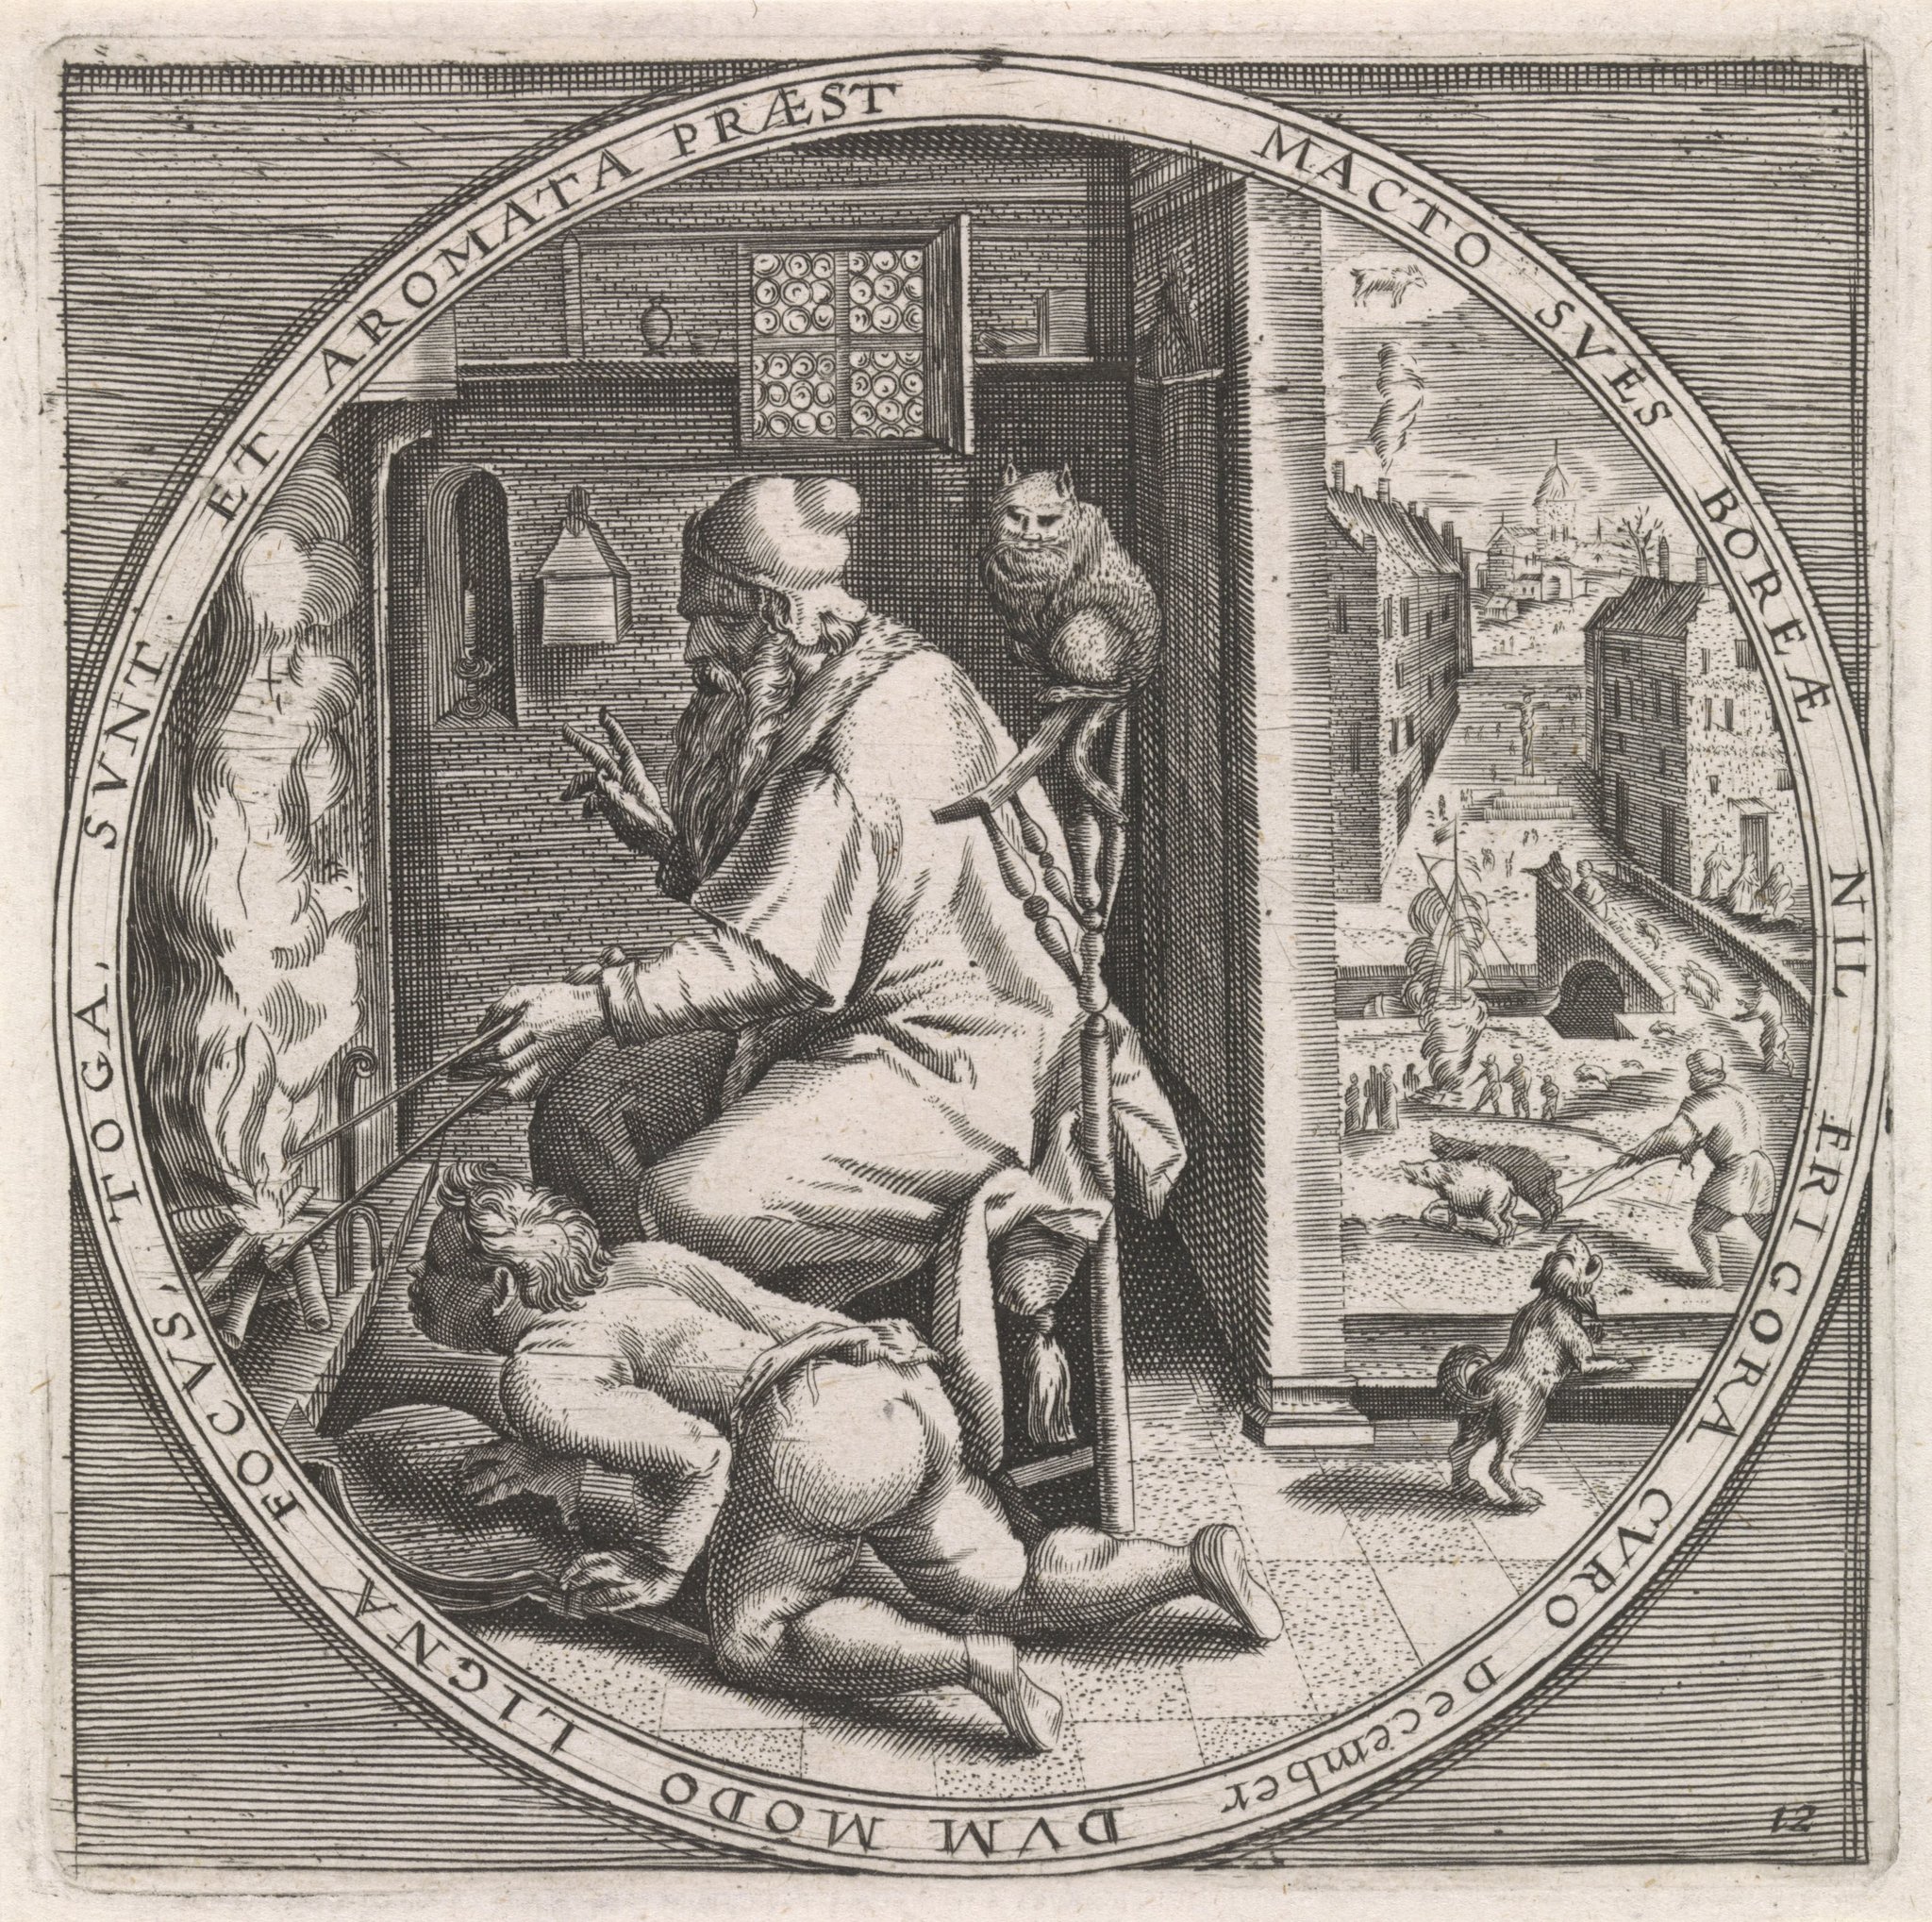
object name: print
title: De twaalf maanden van het jaar verbeeld in scènes uit het volksleven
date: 1574-1687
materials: paper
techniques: engraving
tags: warming oneself at a fire (or hearth, stove, fire-pan, brazier), bellows, december and its 'labours' (+ with zodiacal signs)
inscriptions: collector's mark: Lugt 2228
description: De maand december: een oude man warmt zich aan het vuur van een open haard dat door een jongen wordt aangeblazen. Rechtsboven het teken van de dierenriem dat bij de maand december hoort: Steenbok. De prent heeft een omlijsting met een randschrift in het Latijn dat verwijst naar de werken van de maand december. Kopie in spiegelbeeld naar de gelijknamige prent van Crispijn van de Passe (I).